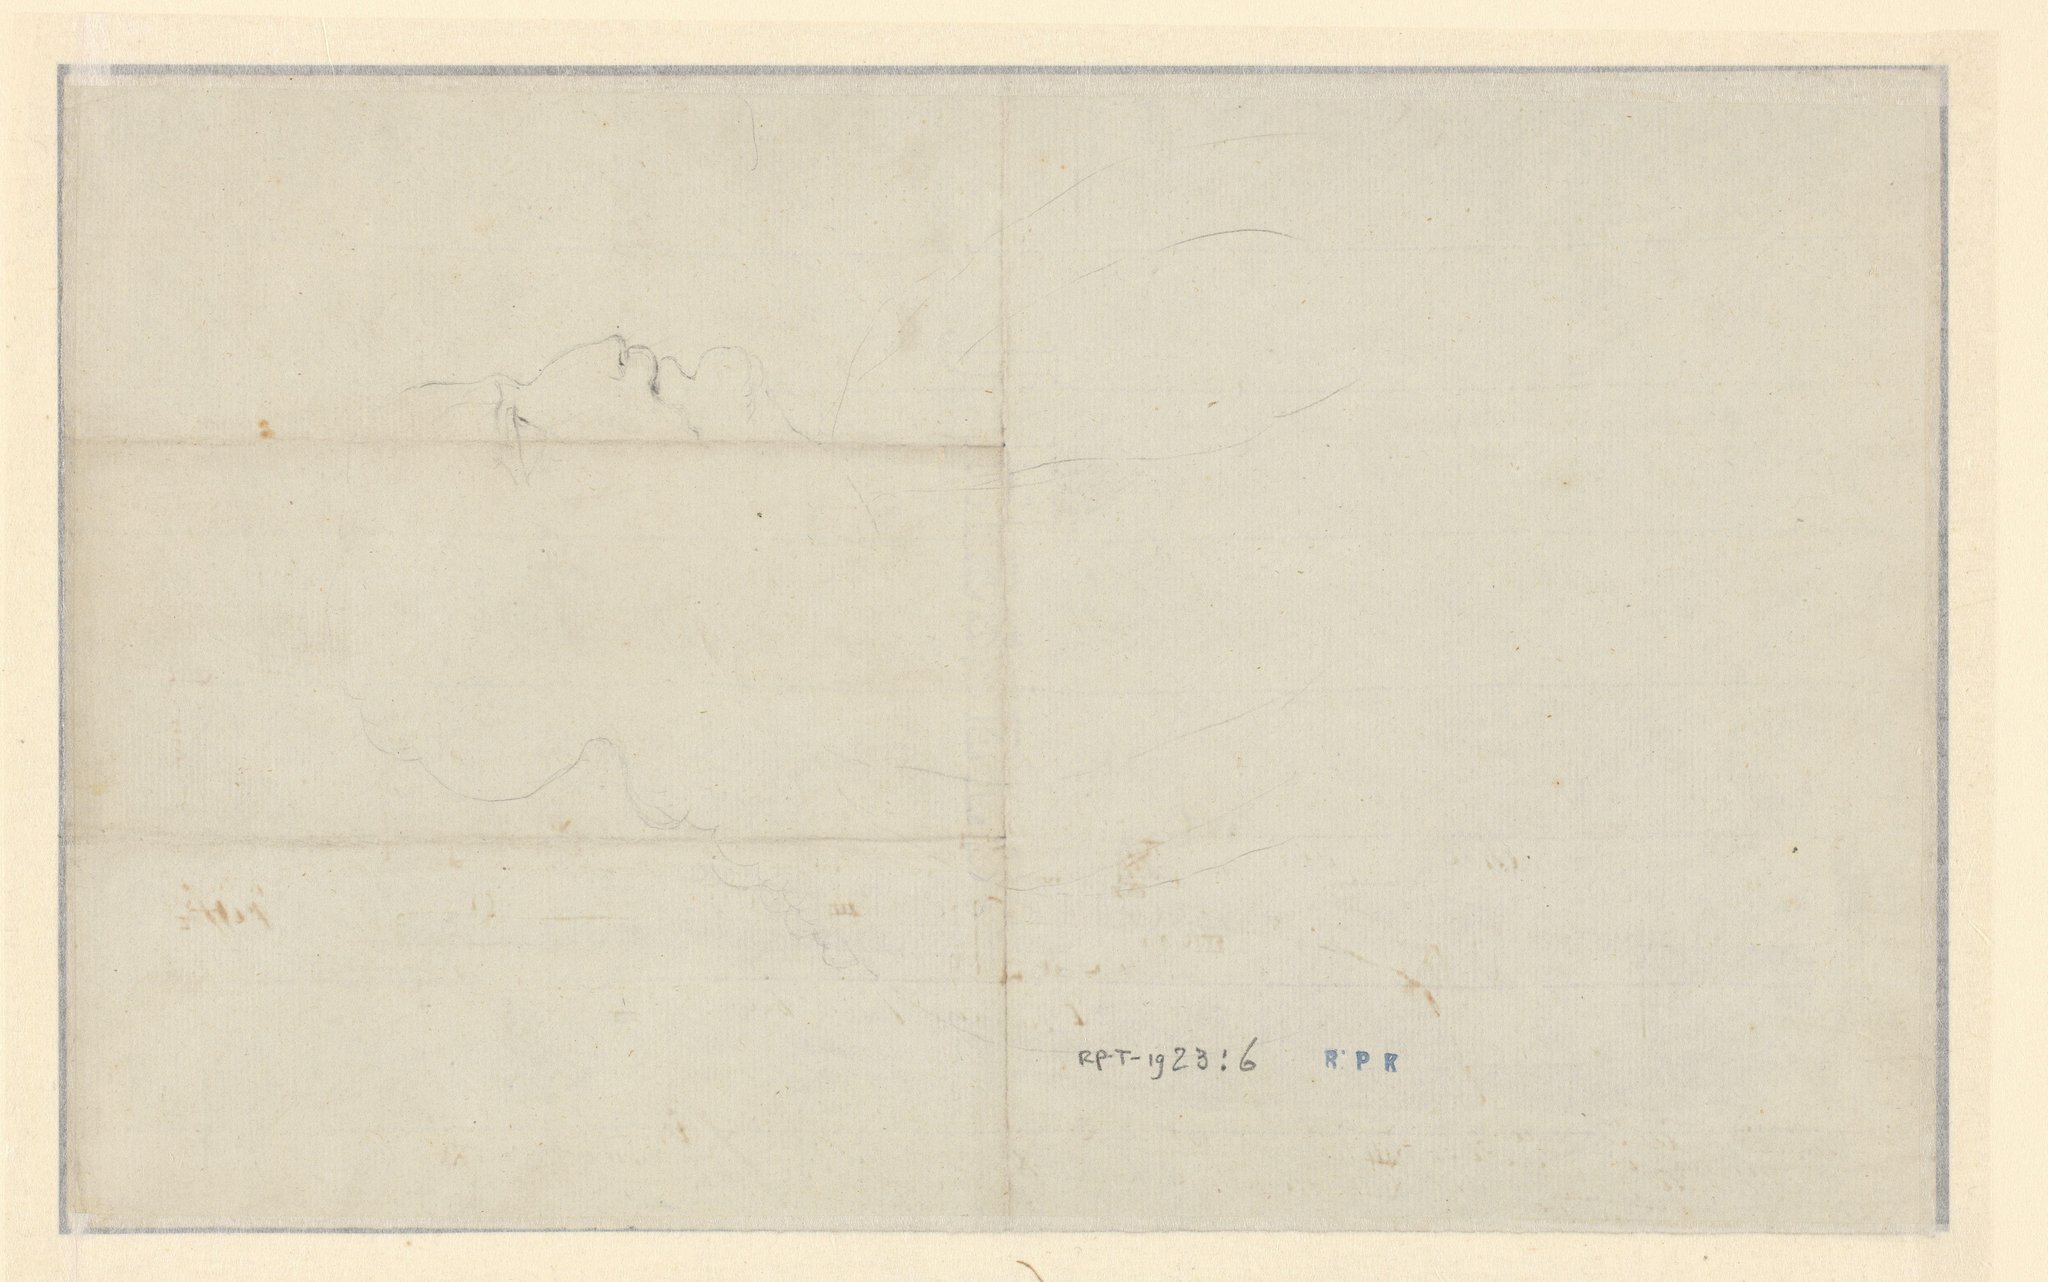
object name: drawing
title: Contourschets van een man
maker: Anonymous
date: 1825-1849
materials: ink, paper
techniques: brush, pen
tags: city-view, and landscape with man-made constructions, antwerp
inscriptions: collector's mark: Lugt 2233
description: Gezicht op Antwerpen met op verso een contourschets van een man.